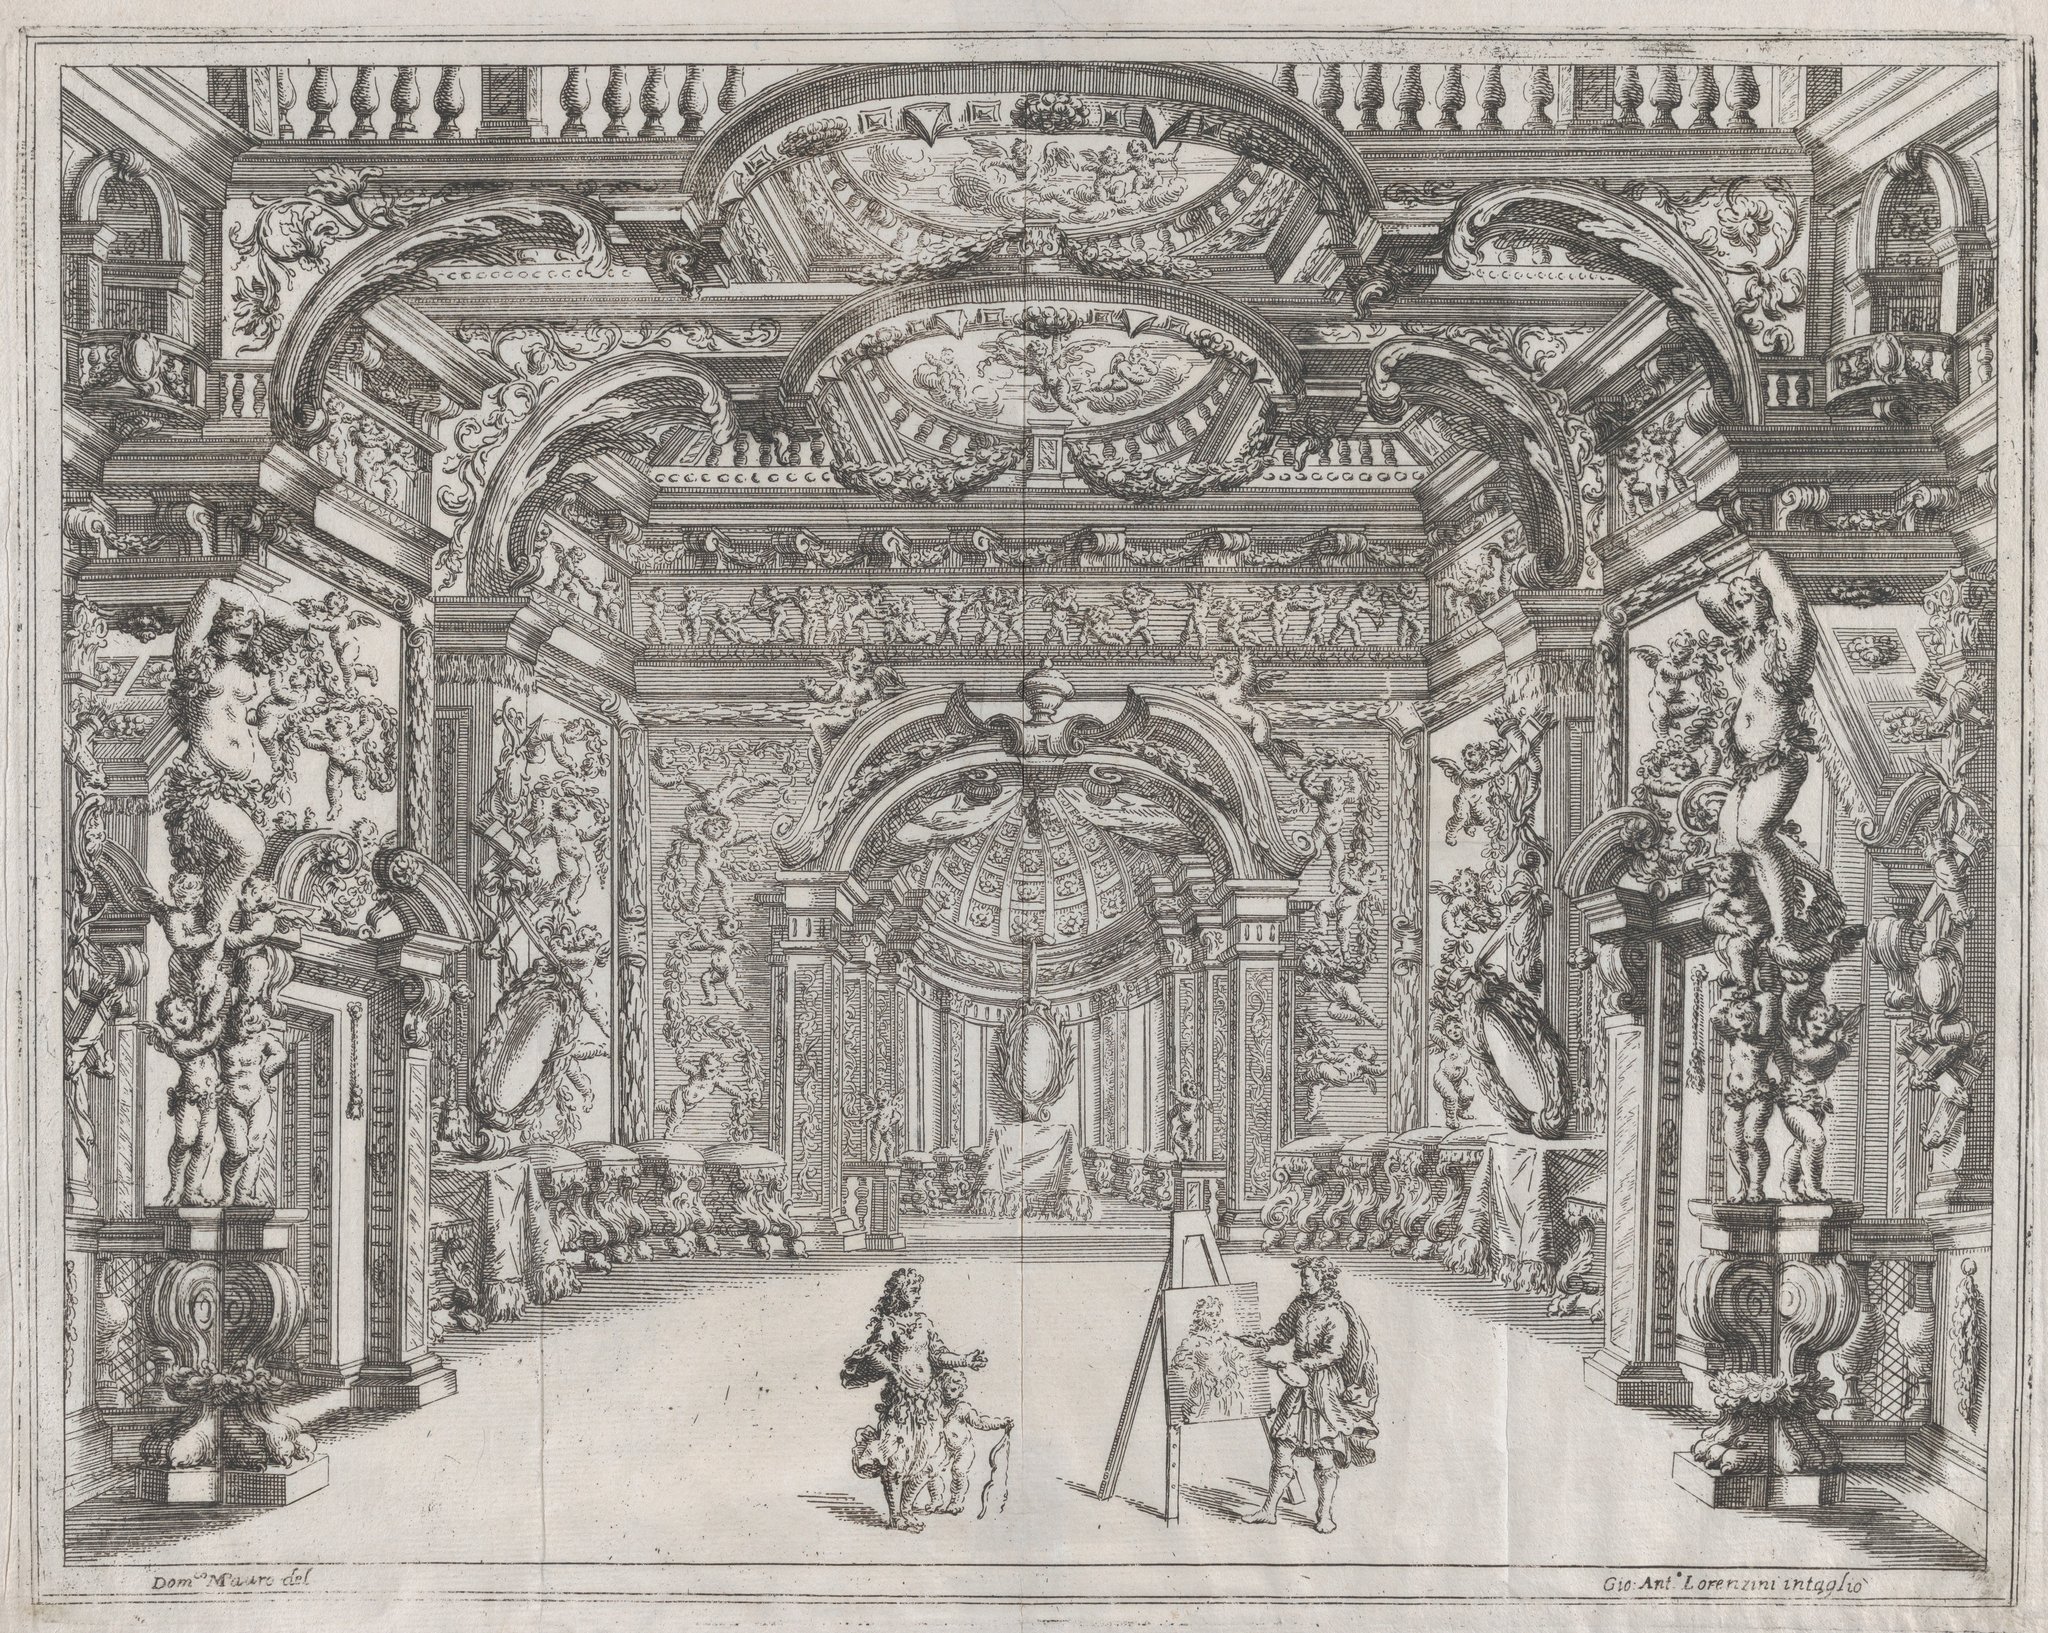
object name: print, fete, ornament architecture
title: Stage set with an artist painting Venus and Cupid; from Aurelio Aureli, 'Il Favore De Gli Dei'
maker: gianantonio lorenzini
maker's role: artist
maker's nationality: italian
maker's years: 1665-1740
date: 1690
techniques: etching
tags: painting,men,cupid,venus,artists,stage design